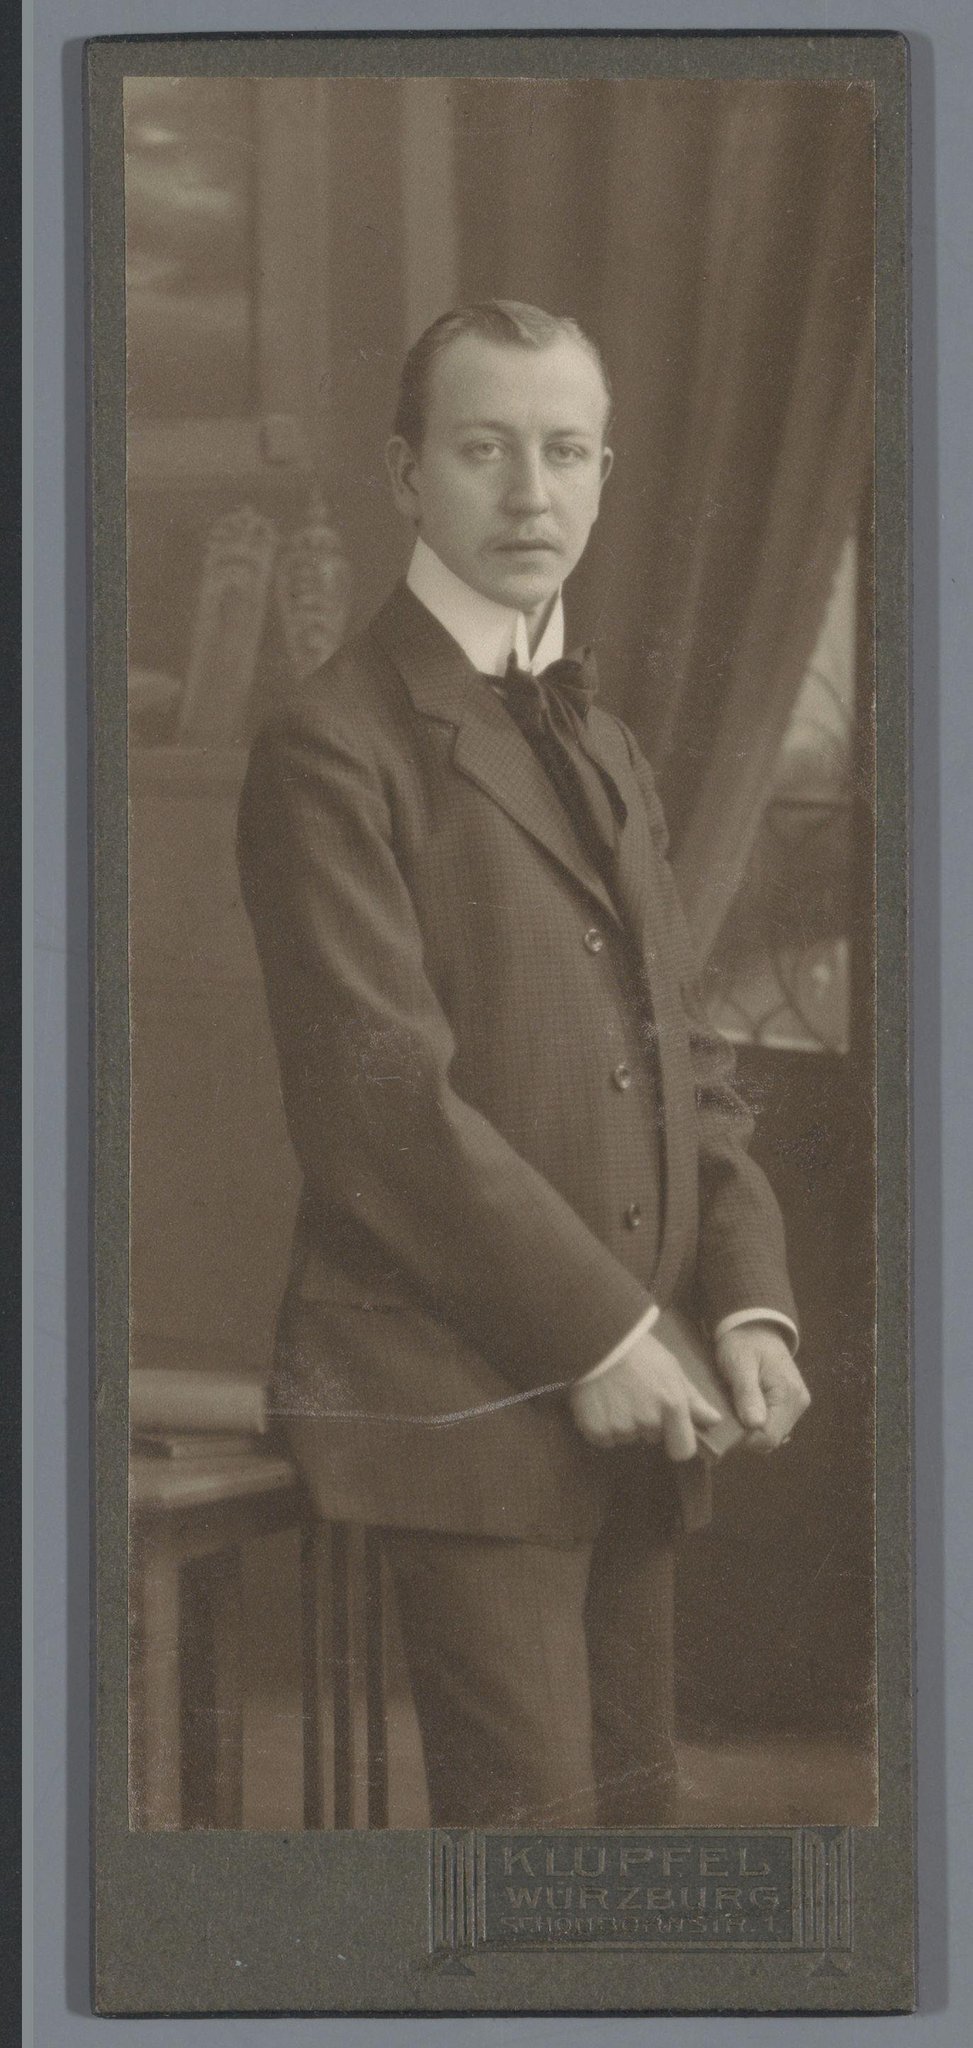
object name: carte de visite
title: Portret van een onbekende man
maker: h. klupfel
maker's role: fotograaf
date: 1900-1914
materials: paper, cardboard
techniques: gelatin silver print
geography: würzburg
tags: adult man, anonymous historical person portrayed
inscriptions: address: ‘WÜRZBURG/ SCHÖNBORNSTR. 1.’